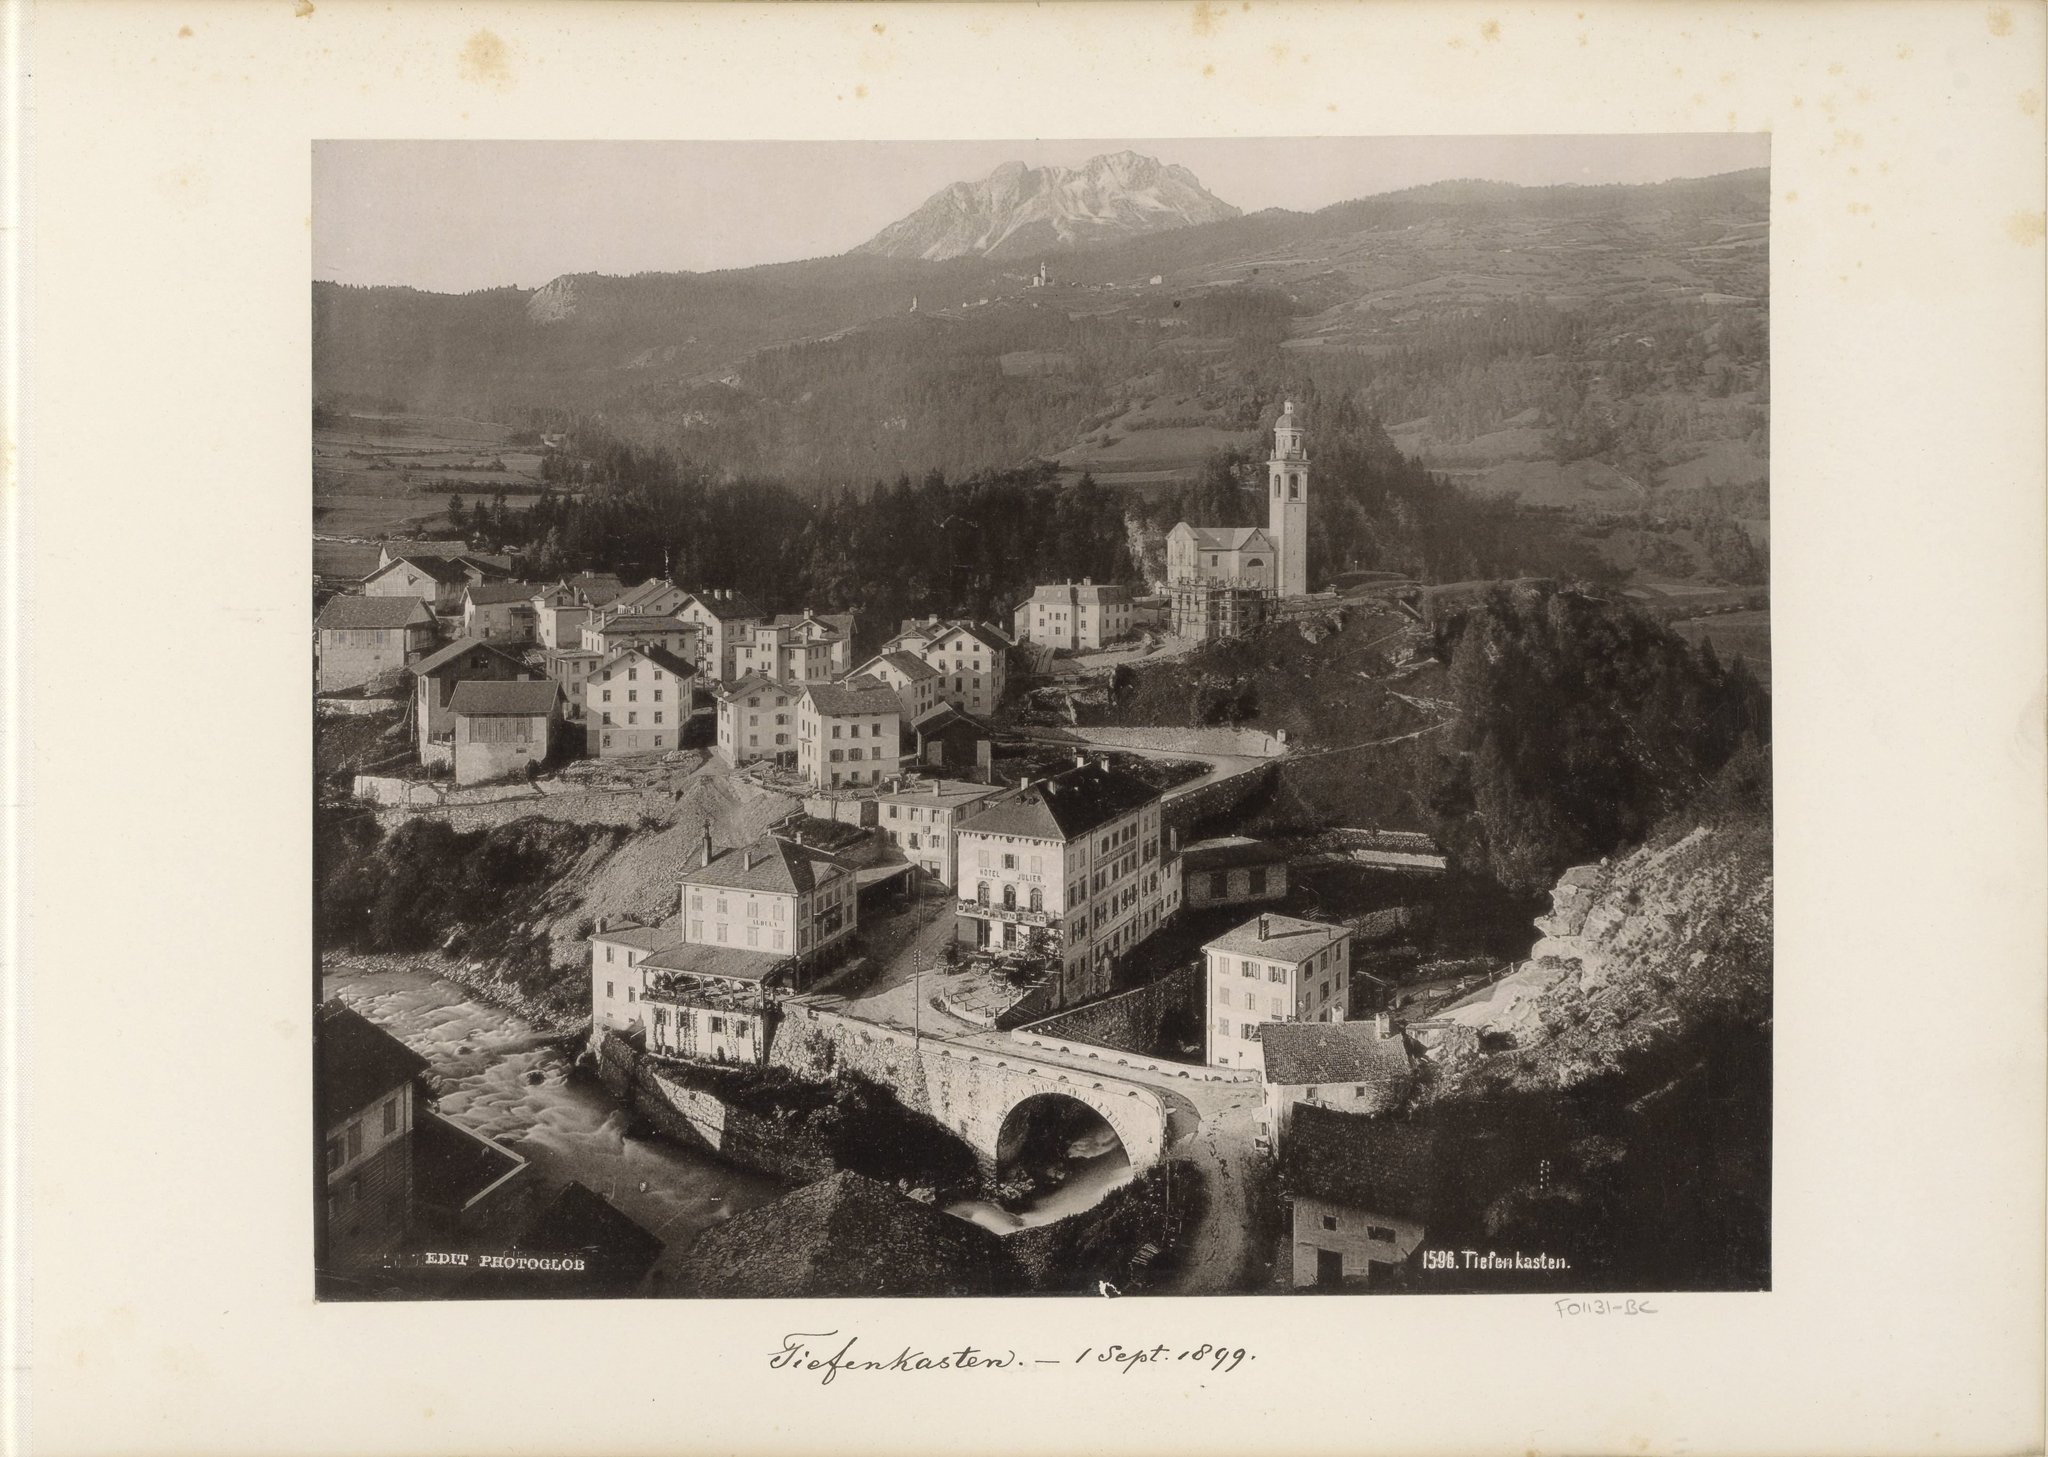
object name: album leaf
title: Tiefenkasten.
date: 1880-1899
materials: paper, photographic support, ink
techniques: photograph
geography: tiefencastel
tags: prospect of village, silhouette of village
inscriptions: number: ‘1596’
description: Onderdeel van Reisalbum met bezienswaardigheden in Duitsland, Oostenrijk, Zwitserland, Luxemburg en België.